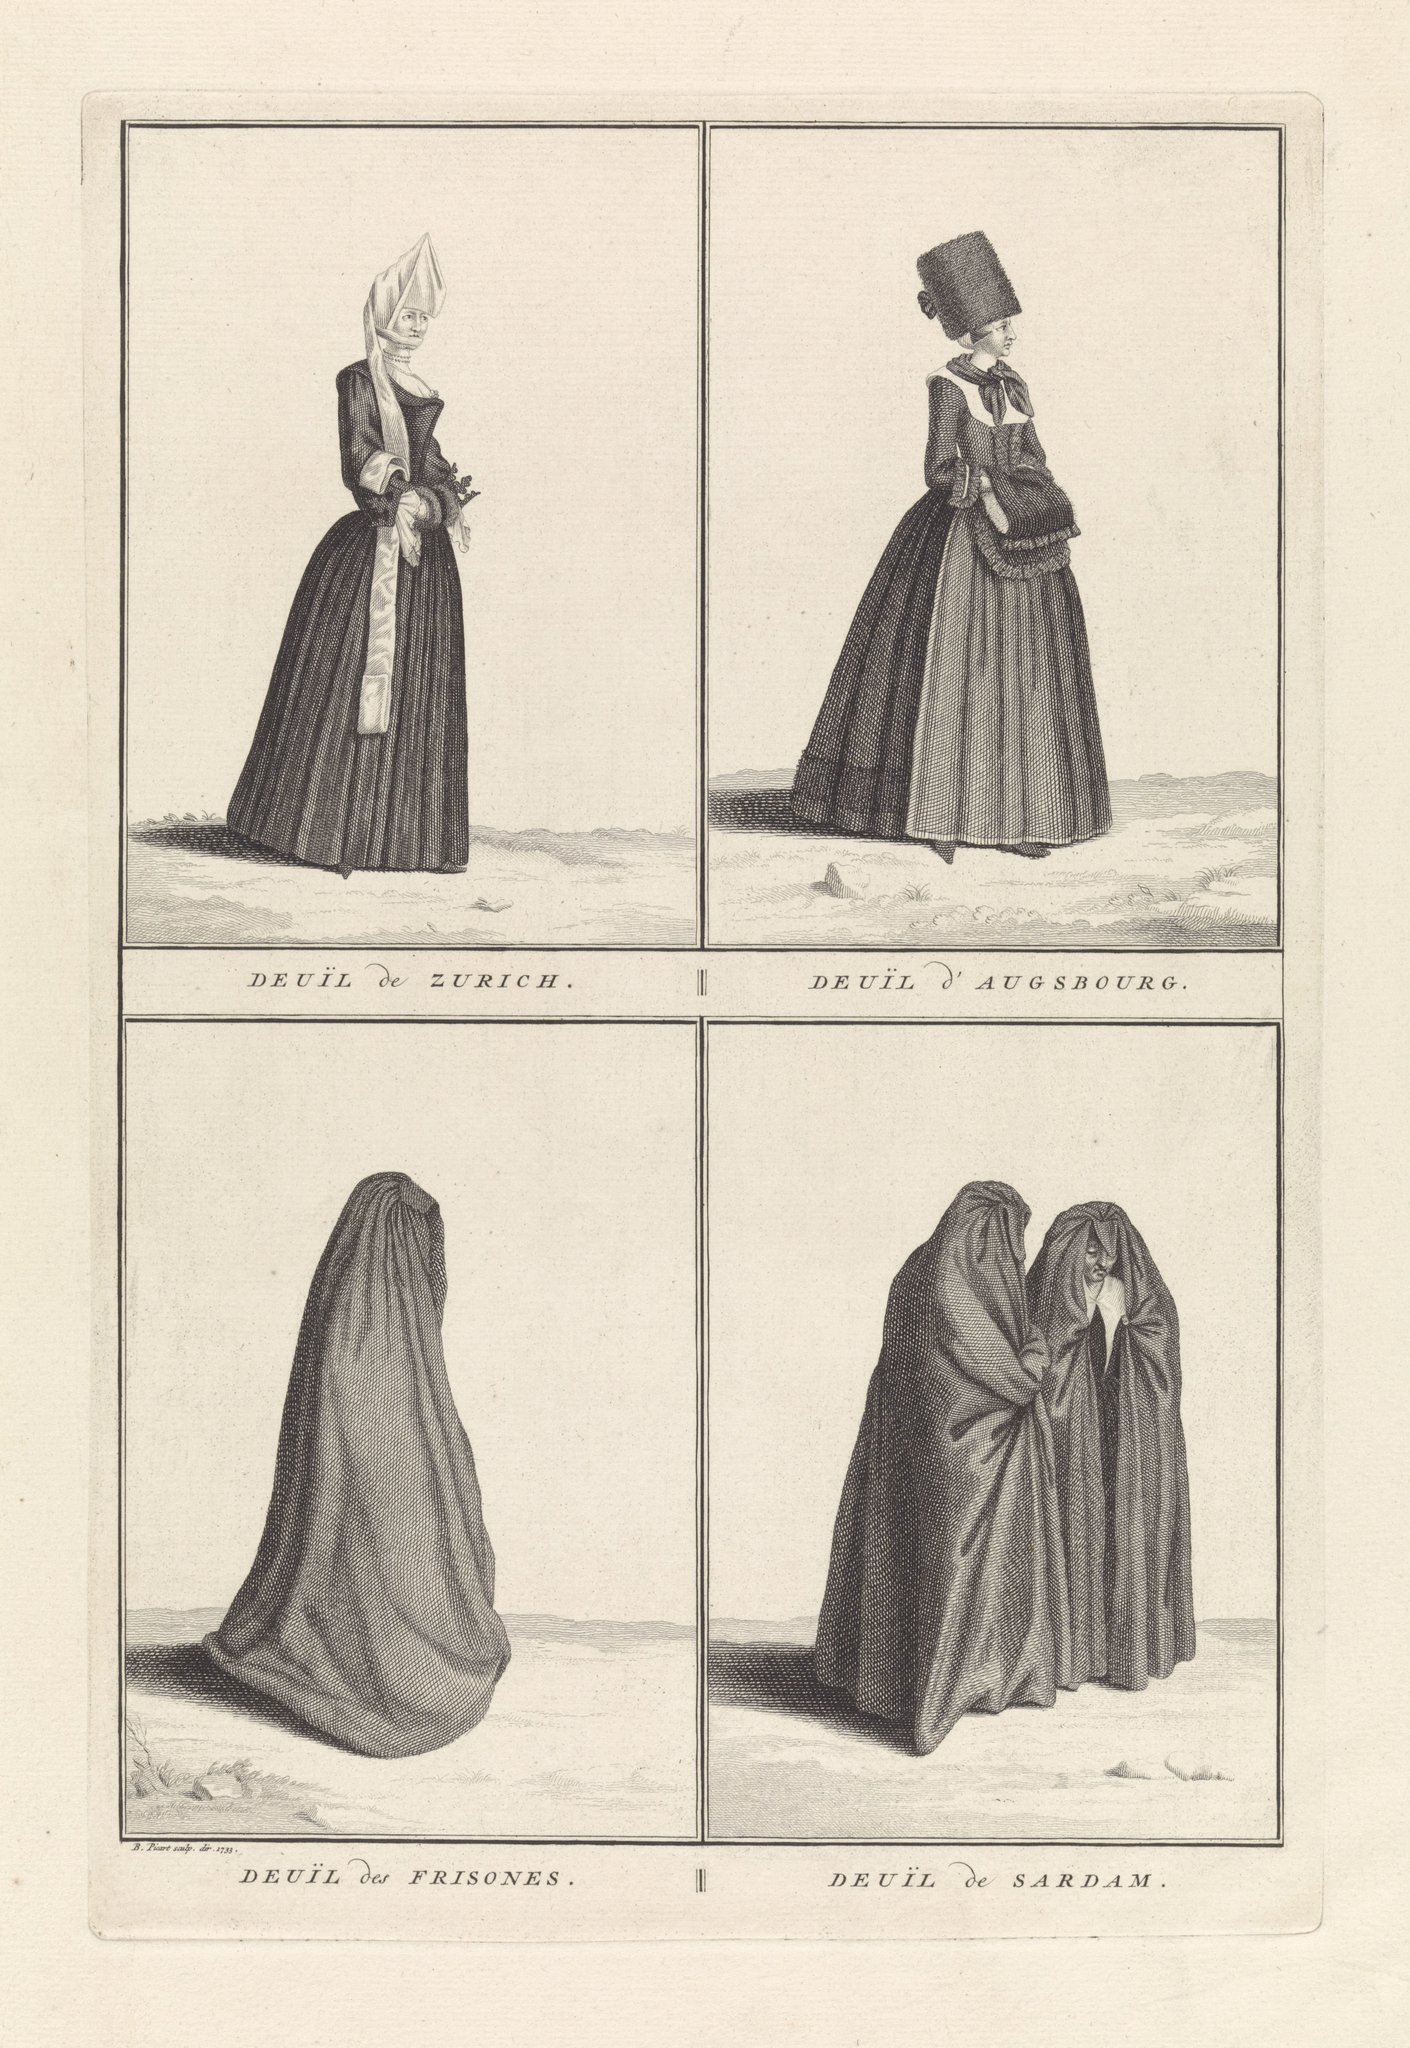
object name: print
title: Verschillende rouwkostuums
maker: bernard picart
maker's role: draughtsman, print maker, publisher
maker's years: 1673-1733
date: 1733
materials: paper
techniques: engraving, etching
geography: amsterdam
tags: fashion plates, mourning dress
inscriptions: collector's mark: Lugt 2228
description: Blad met vier voorstellingen van rouwkostuums. Linksboven: Een vrouw uit Zurich in rouwkostuum. Rechtsboven: Een vrouw uit Augsburg in rouwkostuum. Linksonder: Een Friezin gekleed in een rouwmantel of huik. Rechtsonder: Twee rouwende vrouwen gekleed in een rouwmantel of huik te Zaandam.